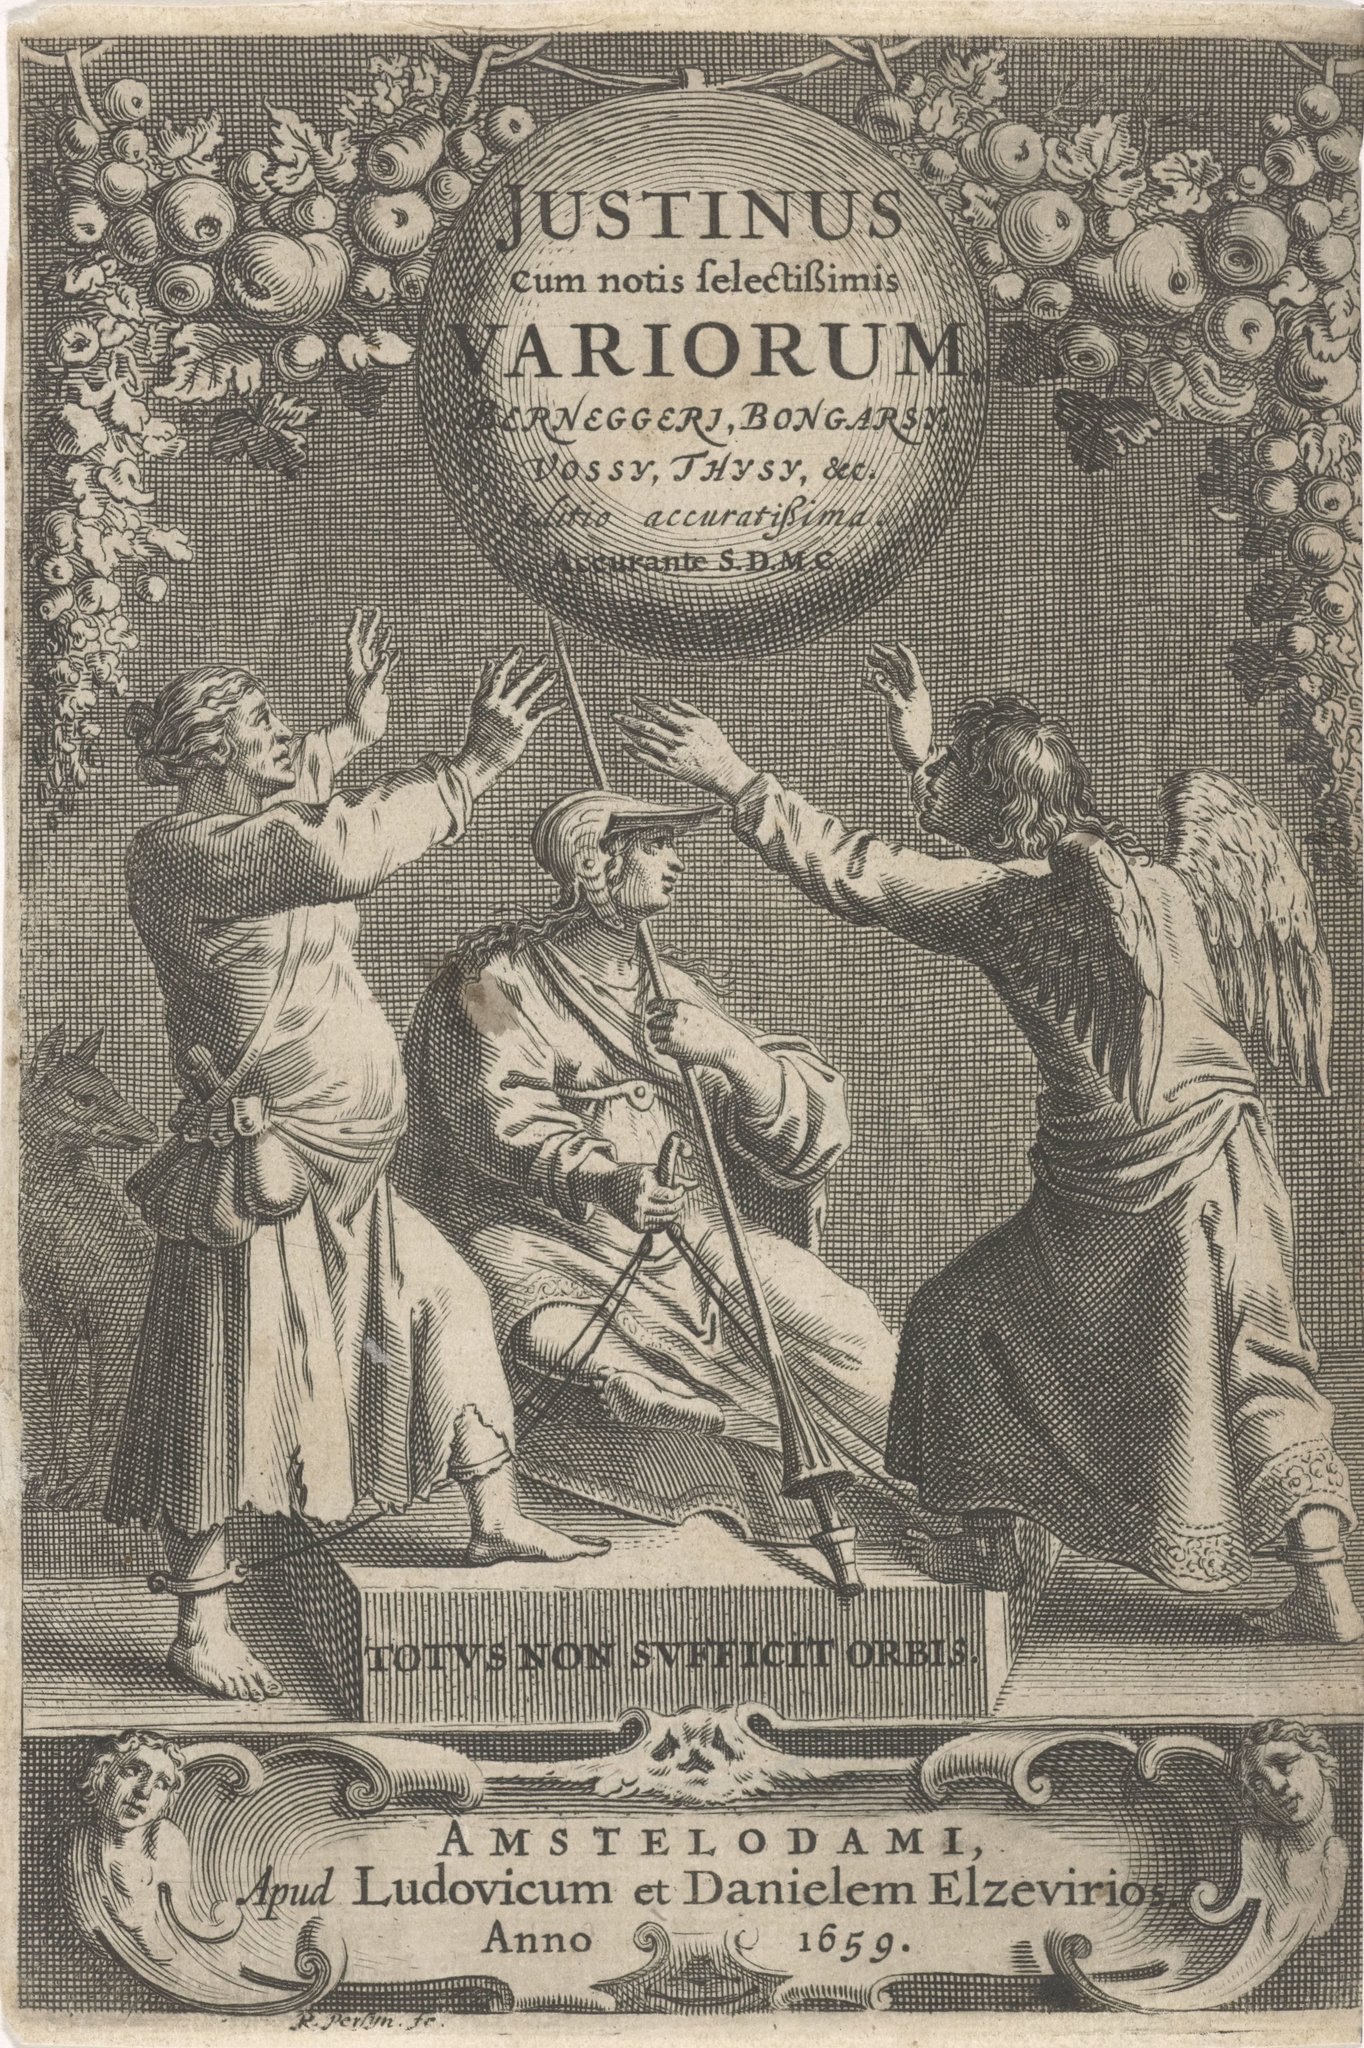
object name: titelblad, titelpagina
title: Minerva en twee geketende figuren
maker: reinier van persijn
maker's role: draughtsman, painter, print maker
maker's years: 1614-1668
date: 1659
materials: paper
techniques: engraving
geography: gouda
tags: (story of) minerva (pallas, athena), prisoner; in fetters, globe, beasts of prey, predatory animals: wolf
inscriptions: collector's mark: Lugt 2228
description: Minerva staat op een piëdestal en houdt een man en een engel vast aan voetboeien. Op de achtergrond een wolf. De geketenden steken hun armen uit naar een (wereld)bol waarop de titel in het Latijn. In de cartouche een impressum in het Latijn.